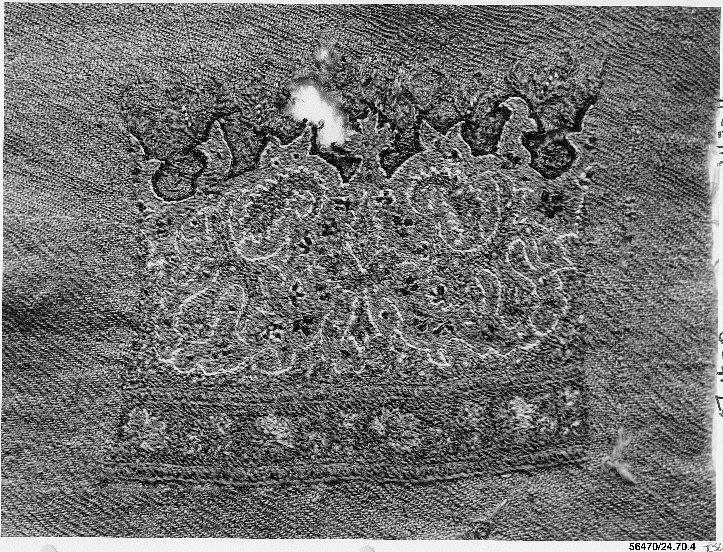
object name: shawl fragment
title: Shawl Sample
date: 1801-1833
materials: wool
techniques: embroidery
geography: india